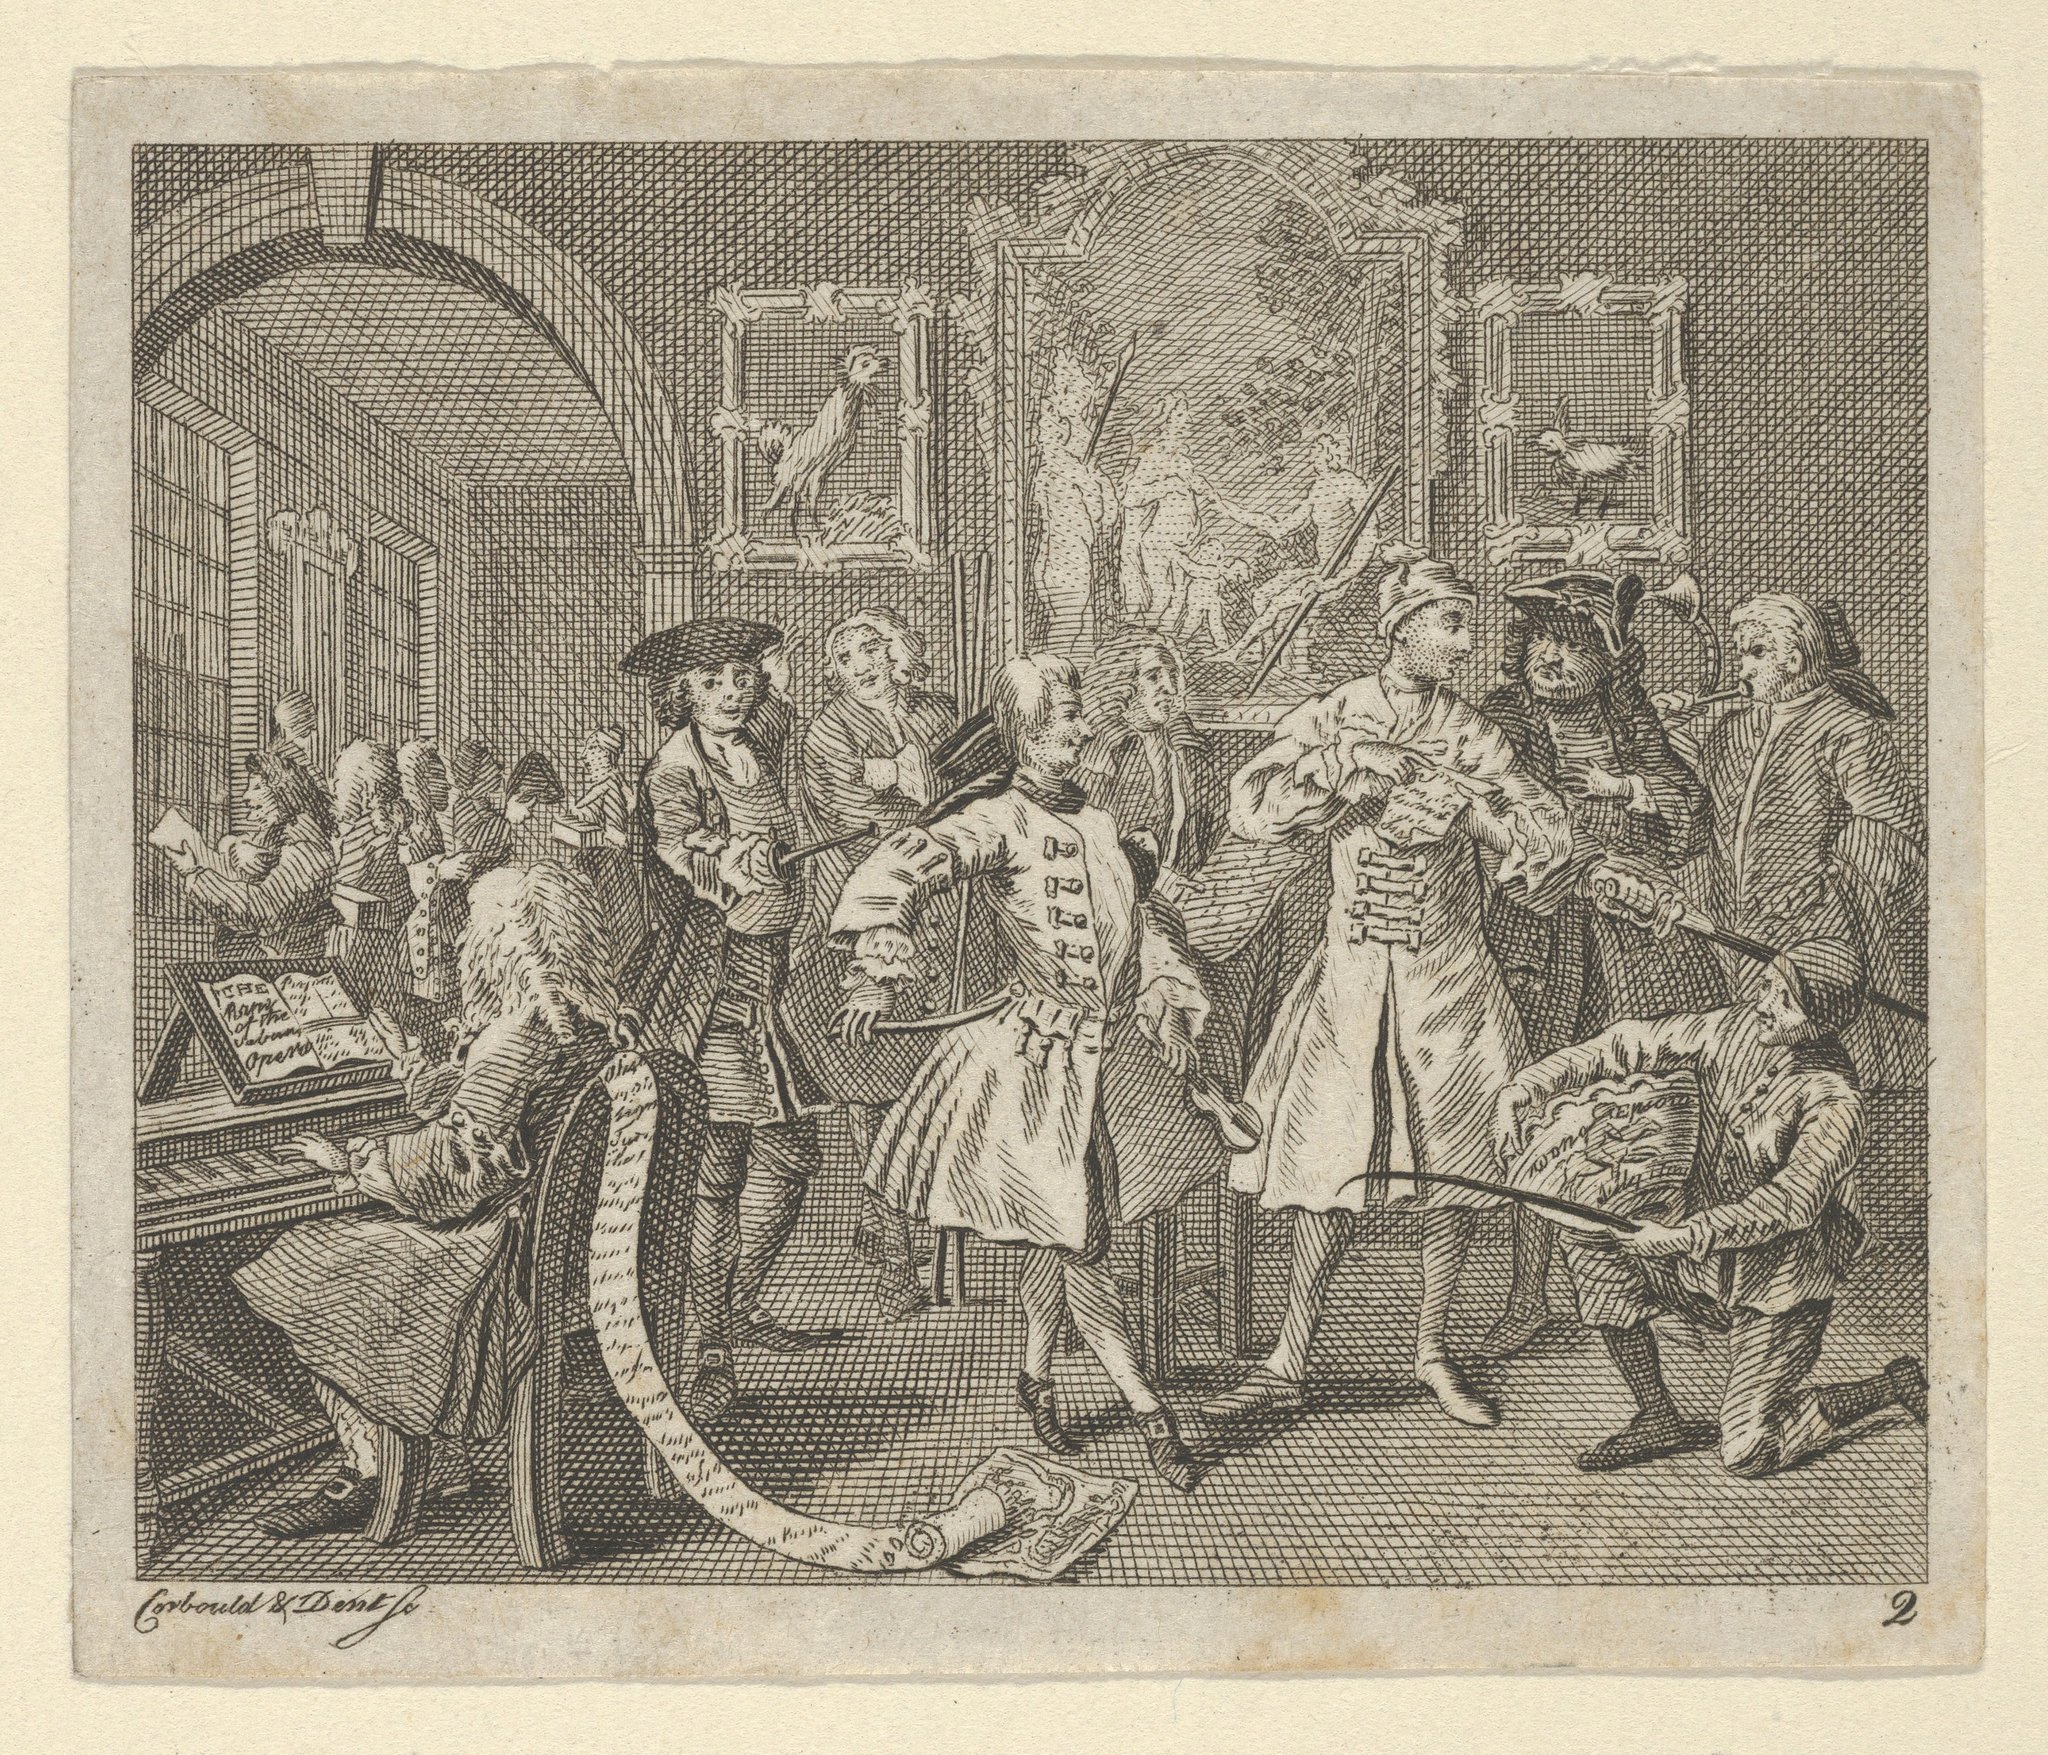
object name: print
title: A Rake's Progress, Plate 2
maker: dent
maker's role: engraver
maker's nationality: british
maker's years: 1800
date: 1800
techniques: engraving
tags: musical instruments,men,music